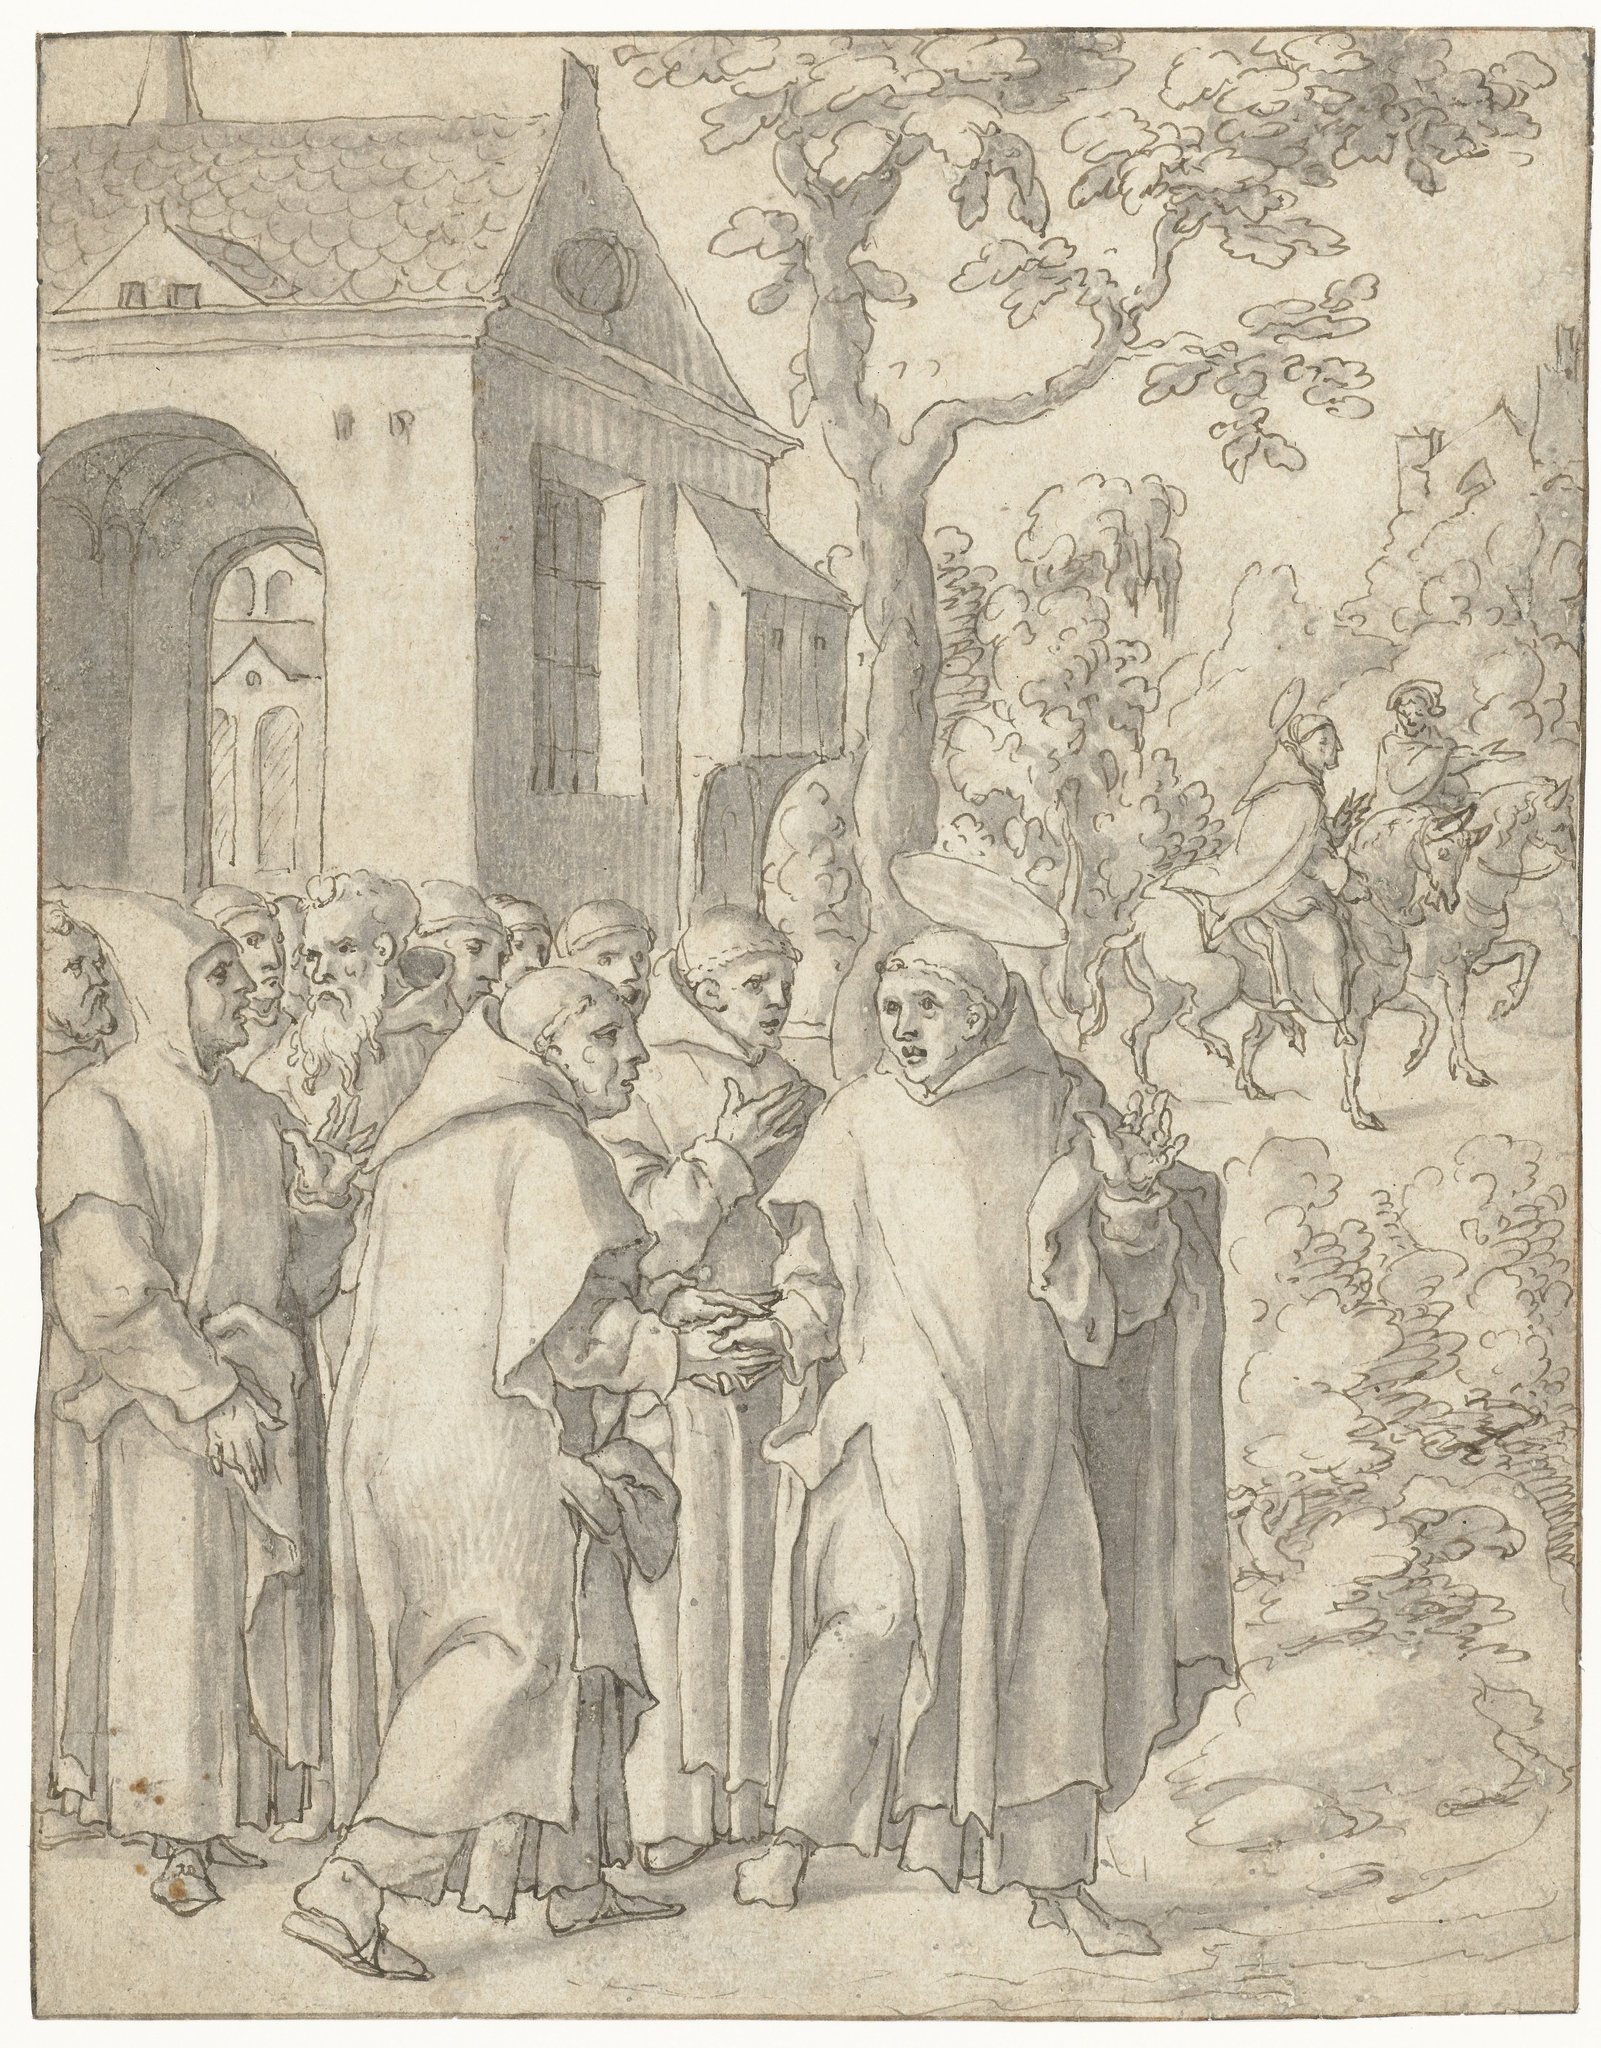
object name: design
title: Leven van H. Bruno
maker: dirck vellert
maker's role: draughtsman, painter, print maker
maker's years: 1480-1547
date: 1500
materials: ink, paper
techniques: brush, pen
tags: the founder of the order of the carthusians, bruno; possible attributes: cross, finger at lips, lily, mitre at his feet, olive-branch, ray of light, skull, (seven) star(s)